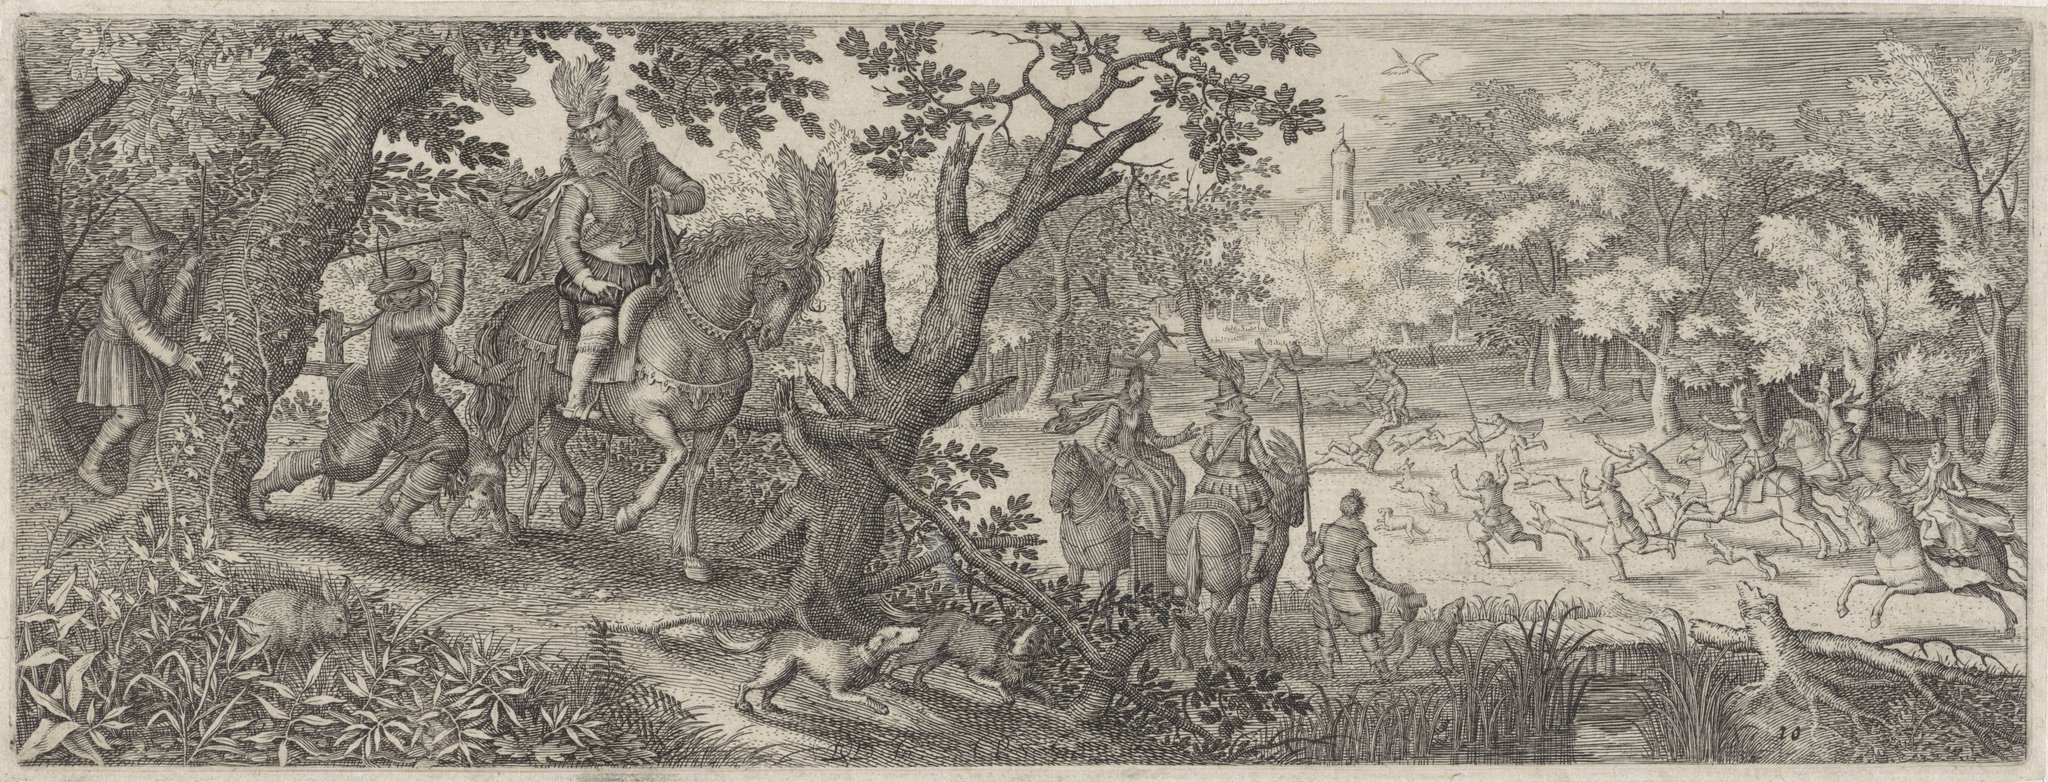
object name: print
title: Konijnenjacht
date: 1612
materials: paper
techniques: engraving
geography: amsterdam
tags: hunting, chase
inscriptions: collector's mark: Lugt 2228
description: Een heer te paard rijdt met zijn dienaren en honden over een bospad. Een van de dienaren haalt met een stok uit naar een konijn aan de kant van de weg. Een andere heer en een dame te paard kijken uit over een open plek iin het bos, waar een drijfjacht plaats vindt.